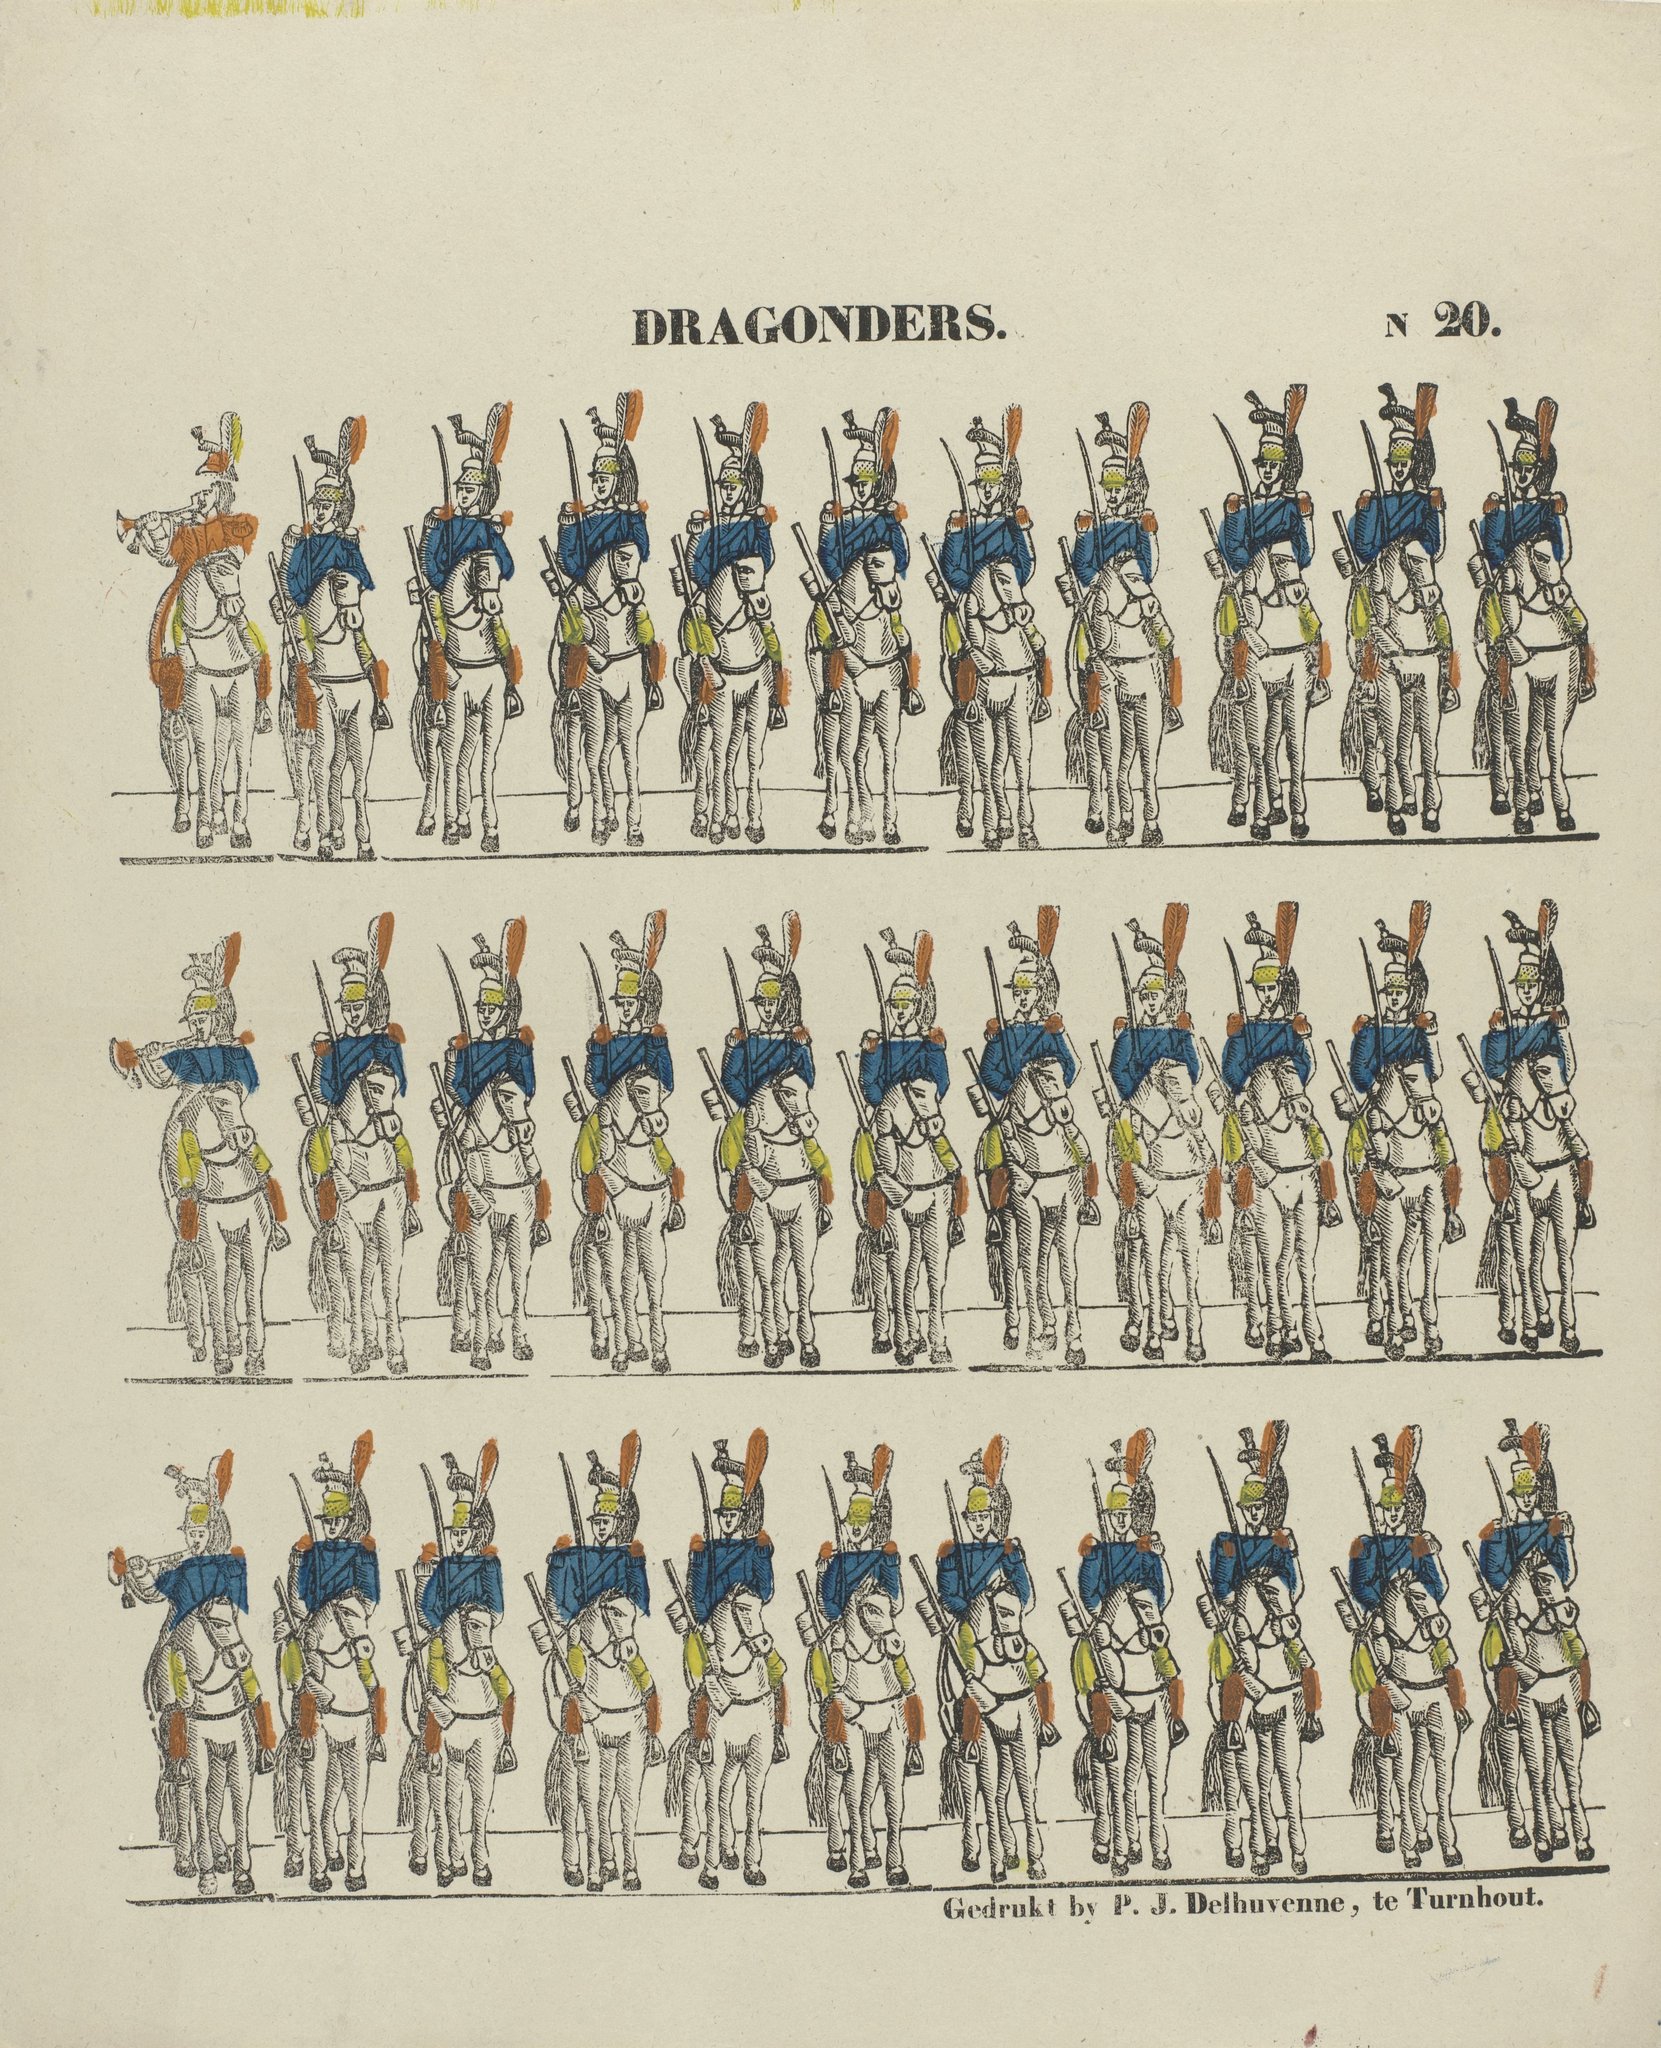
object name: popular print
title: Dragonders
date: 1842-1856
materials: paper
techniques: colour, letterpress printing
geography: turnhout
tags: warfare; military affairs (+ cavalry, horsemen)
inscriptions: collector's mark: Lugt 2760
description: Blad met drie horizontale rijen met elk 11 dragonders (soldaten te paard) van voren gezien. De meest linker steeds met een trompet. Genummerd rechtsboven: N 20.